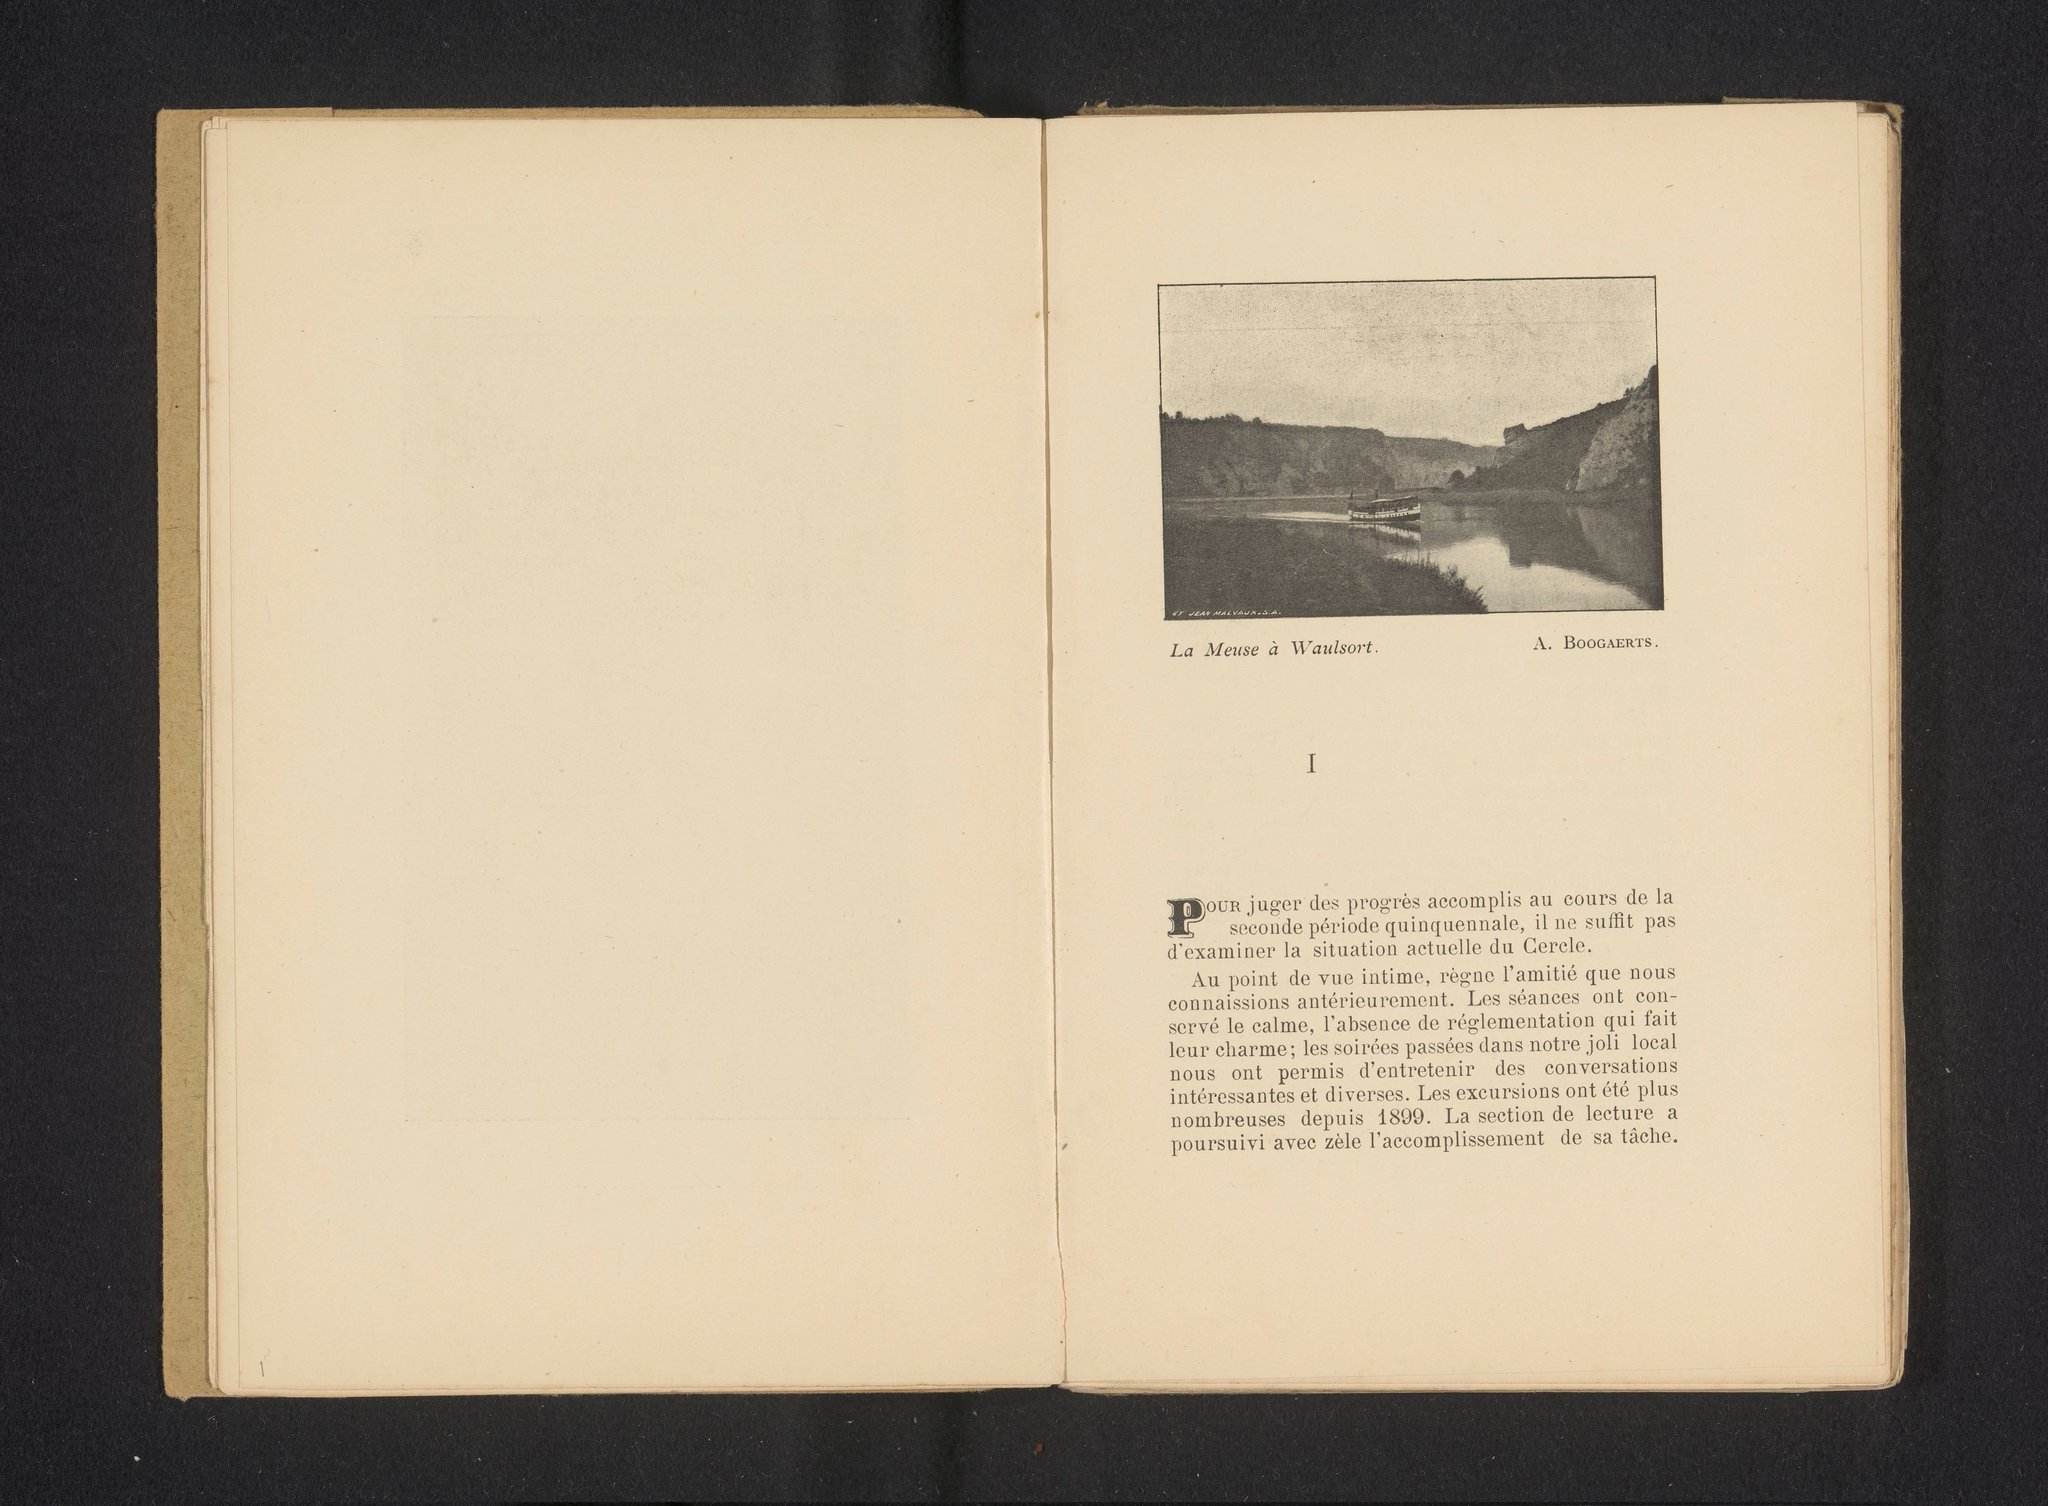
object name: page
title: Gezicht op de Maas nabij Waulsort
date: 1896-1901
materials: paper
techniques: autotype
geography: waulsort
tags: river